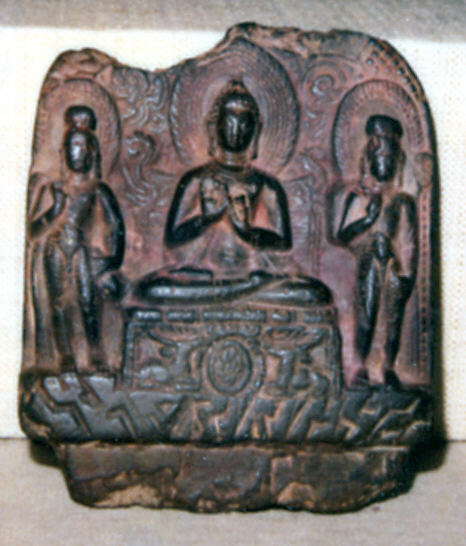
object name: stele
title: Buddha Preaching the First Sermon Attended by Maitreya and Padmapani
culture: nepali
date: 701-900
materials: stone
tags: buddhism,bodhisattvas,buddha,maitreya